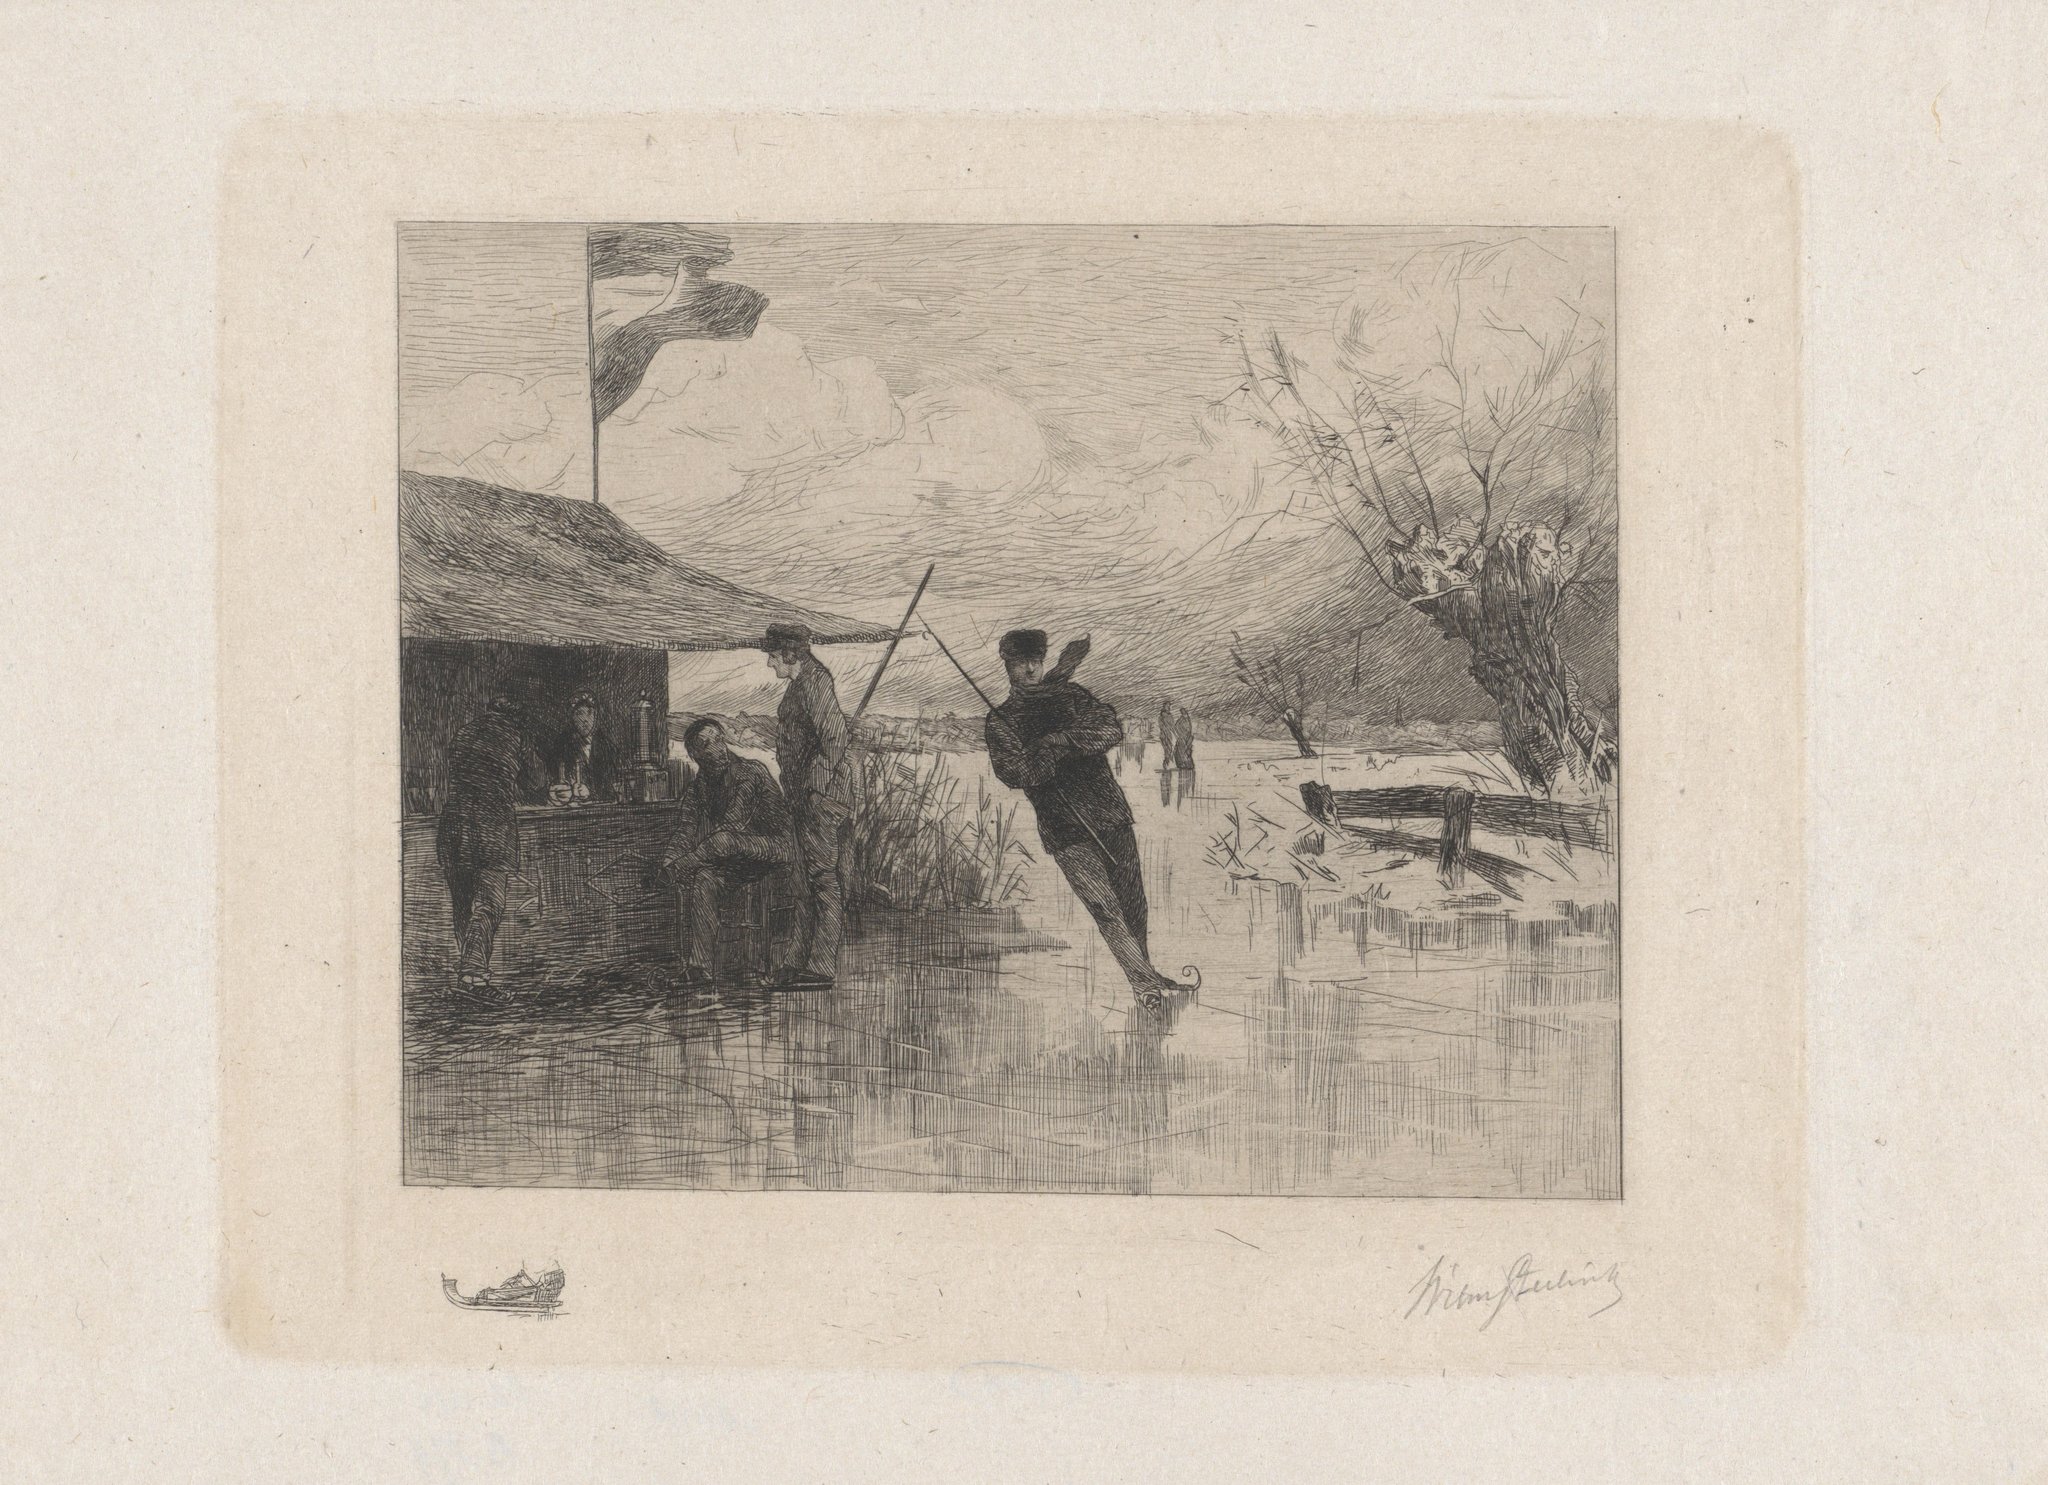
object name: print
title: Schaatser en verkoopster op het ijs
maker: willem steelink (ii)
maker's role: draughtsman, print maker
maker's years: 1856-1928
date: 1866-1886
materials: paper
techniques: etching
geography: netherlands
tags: stall, booth (~ market), skates (winter sports)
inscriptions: collector's mark: Lugt 2228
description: Een schaatser op het ijs. Links een kraam met een verkoopster en enkele mannen aan de toonbank. Linksonder in de marge een schaats.